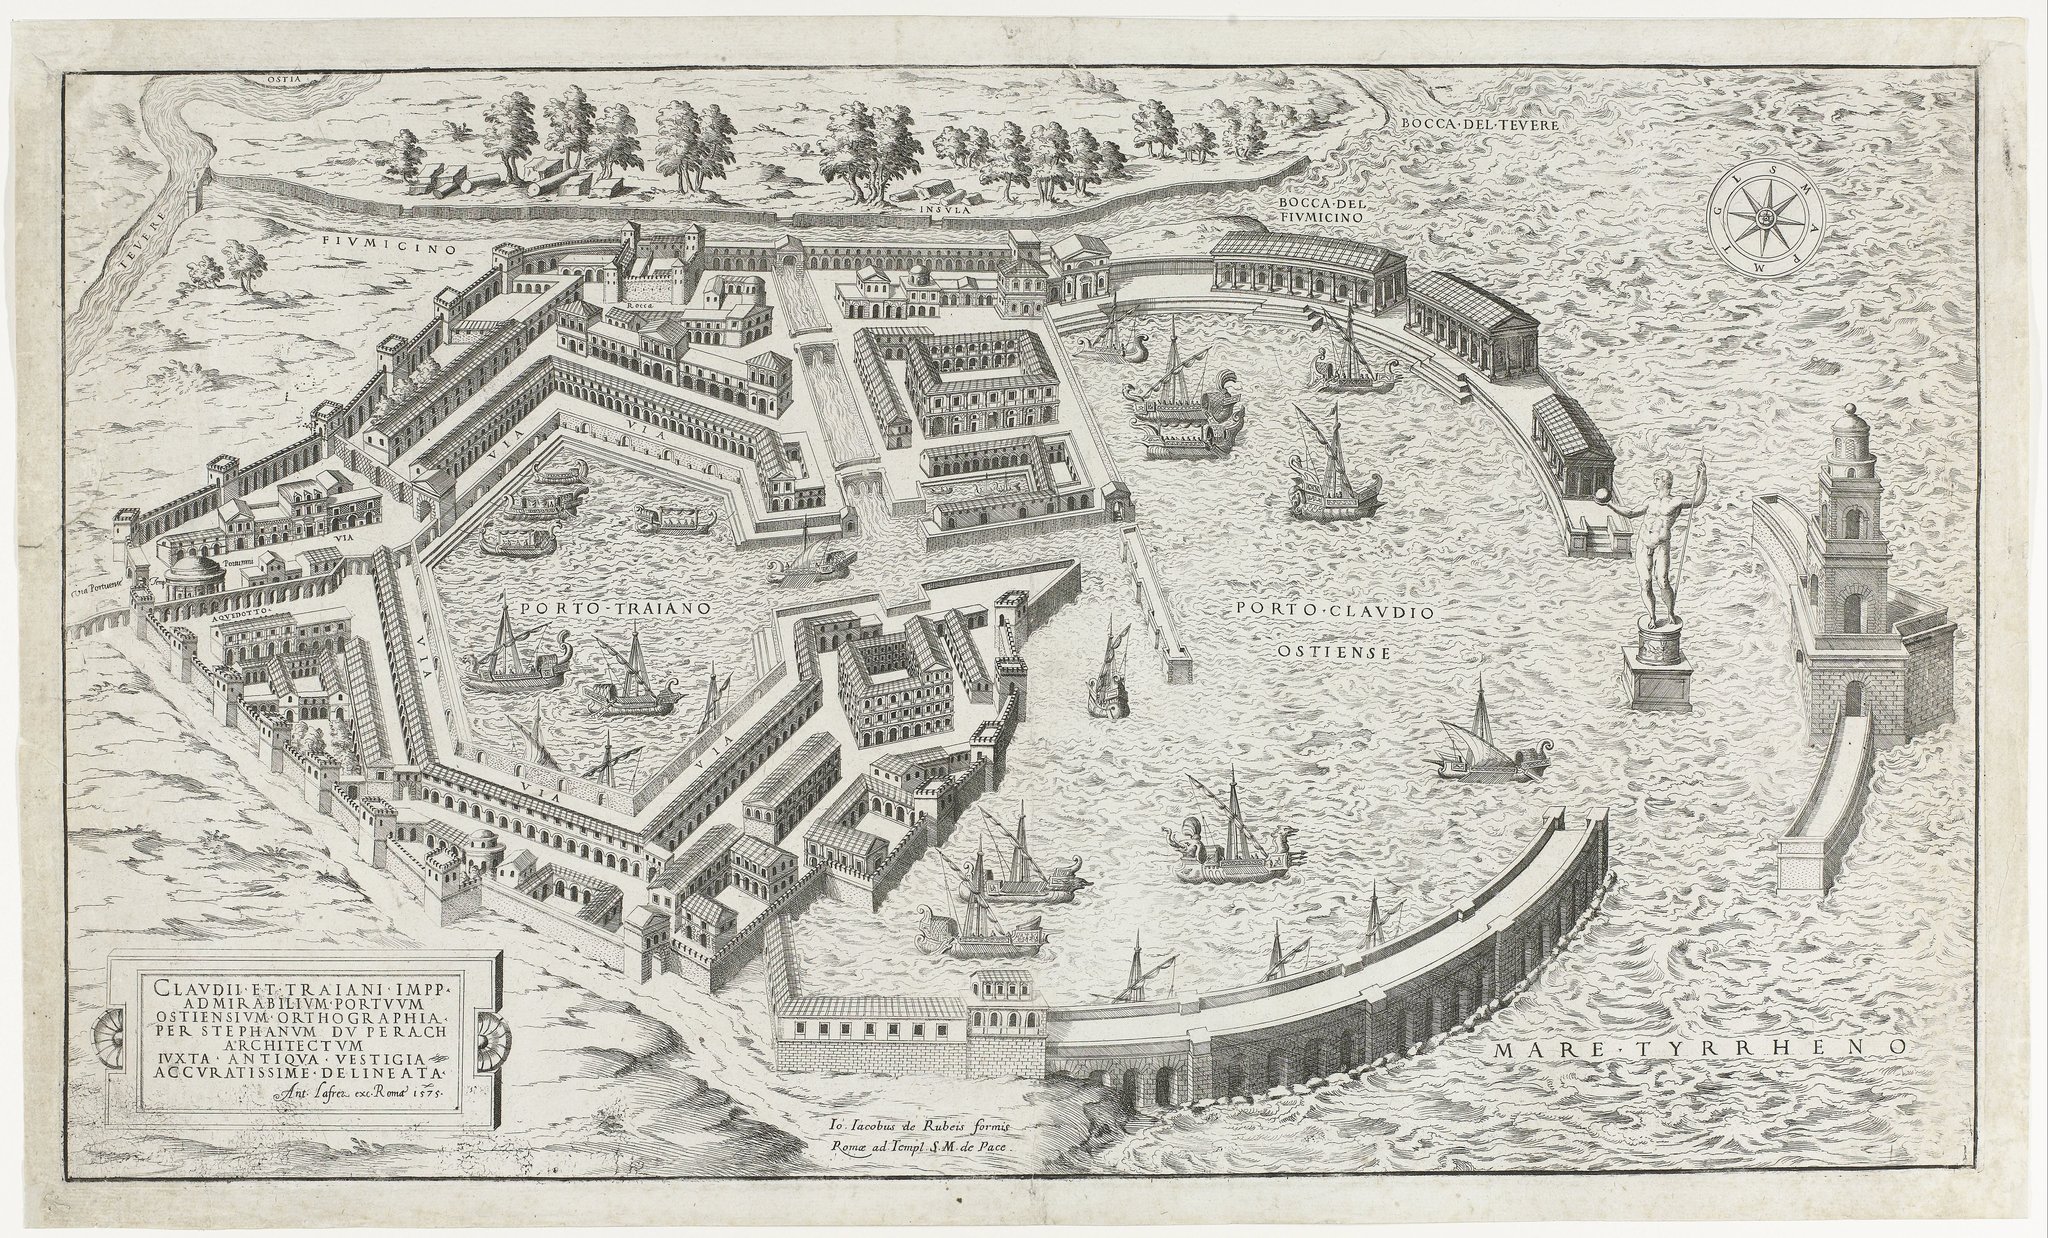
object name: print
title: Reconstructie van de antieke haven van Ostia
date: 1575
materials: paper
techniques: engraving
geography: italy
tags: harbour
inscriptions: collector's mark: Lugt 2228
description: Deze prent behoort tot het prentcorpus dat bekend staat als de ‘Speculum Romanae Magnificentiae’ (‘Spiegel van Romeinse pracht’). Dit corpus, bestaande uit prenten met voorstellingen van kunstwerken en gebouwen uit het antieke en het moderne Rome, vond zijn oorsprong bij uitgevers Antonio Salamanca en Antonio Lafreri. Deze twee buitenlandse uitgevers bundelden hun krachten te Rome in de periode 1553-1563. Hun prenten werden al snel razend populair bij toeristen en verzamelaars, die de prenten individueel of in grote groepen aanschaften. Grote groepen Speculum-prenten werden vaak op aanvraag samengebonden in albums. Er zijn verschillende Speculum-albums overgeleverd die allemaal verschillen van inhoud. Tussen 1573 en 1577 gaf Antonio Lafreri een speciale titelpagina uit (met de titel ‘Speculum Romanae Magnificentiae’) die mensen voor hun verzamelingen konden voegen. Het overlijden van Lafreri in 1577 betekende niet het einde van het corpus. Een groot deel van de koperplaten ging over op Claudio en Stefano Duchetti. De rest raakte verspreid over verschillende andere uitgevers. De populariteit van de Speculum-prenten wist nog geruime periode uitgevers te inspireren tot het laten maken van kopieën en het toevoegen van nieuwe prenten aan het corpus.